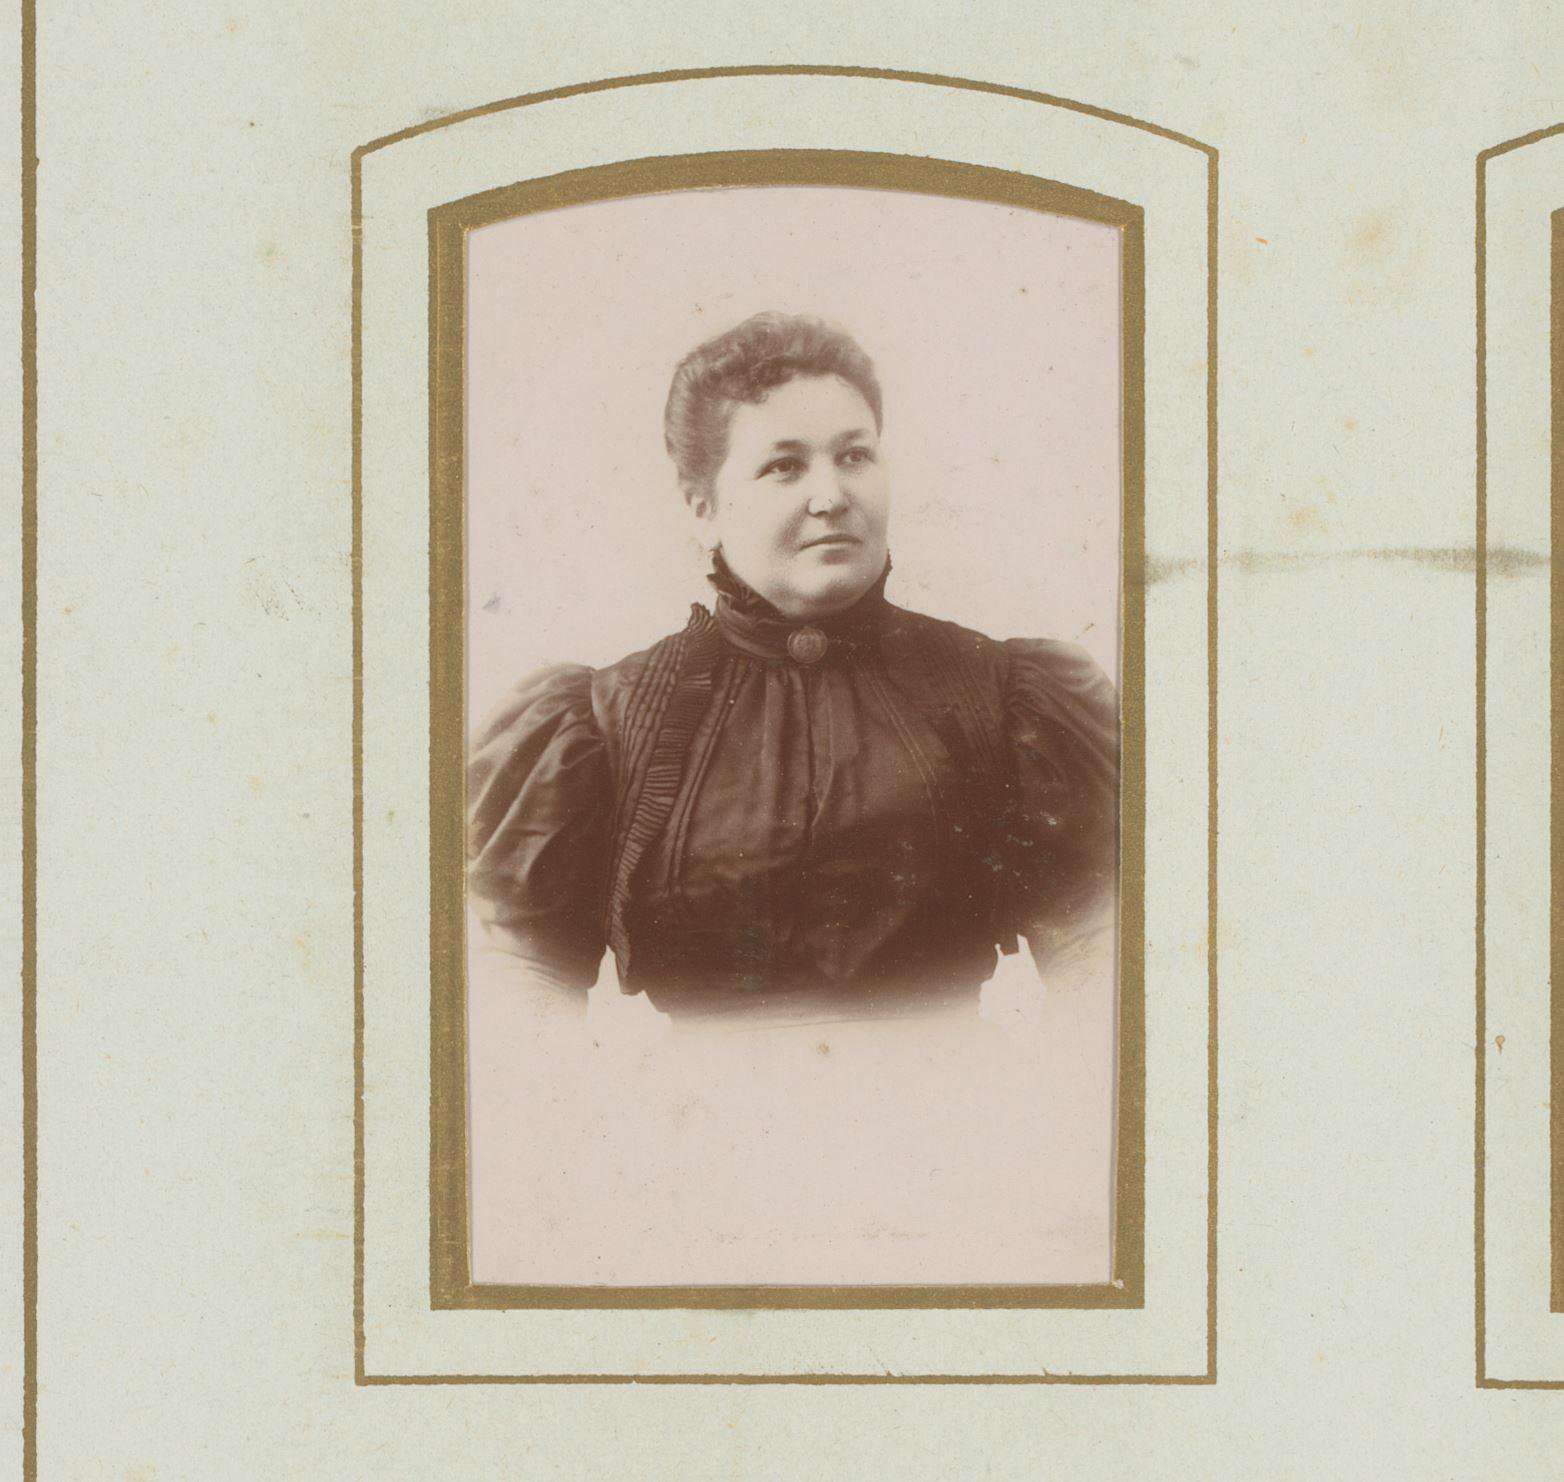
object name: photograph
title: Portret van een vrouw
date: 1880-1920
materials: cardboard, photographic support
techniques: collodion silver print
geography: paris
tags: historical persons - bb - woman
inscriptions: inscription: ‘Photographie/ Artistique/ Raoult Ensch/ 249/ Faub. g St. Martin/ Paris/ Les Clichés sont conservés’